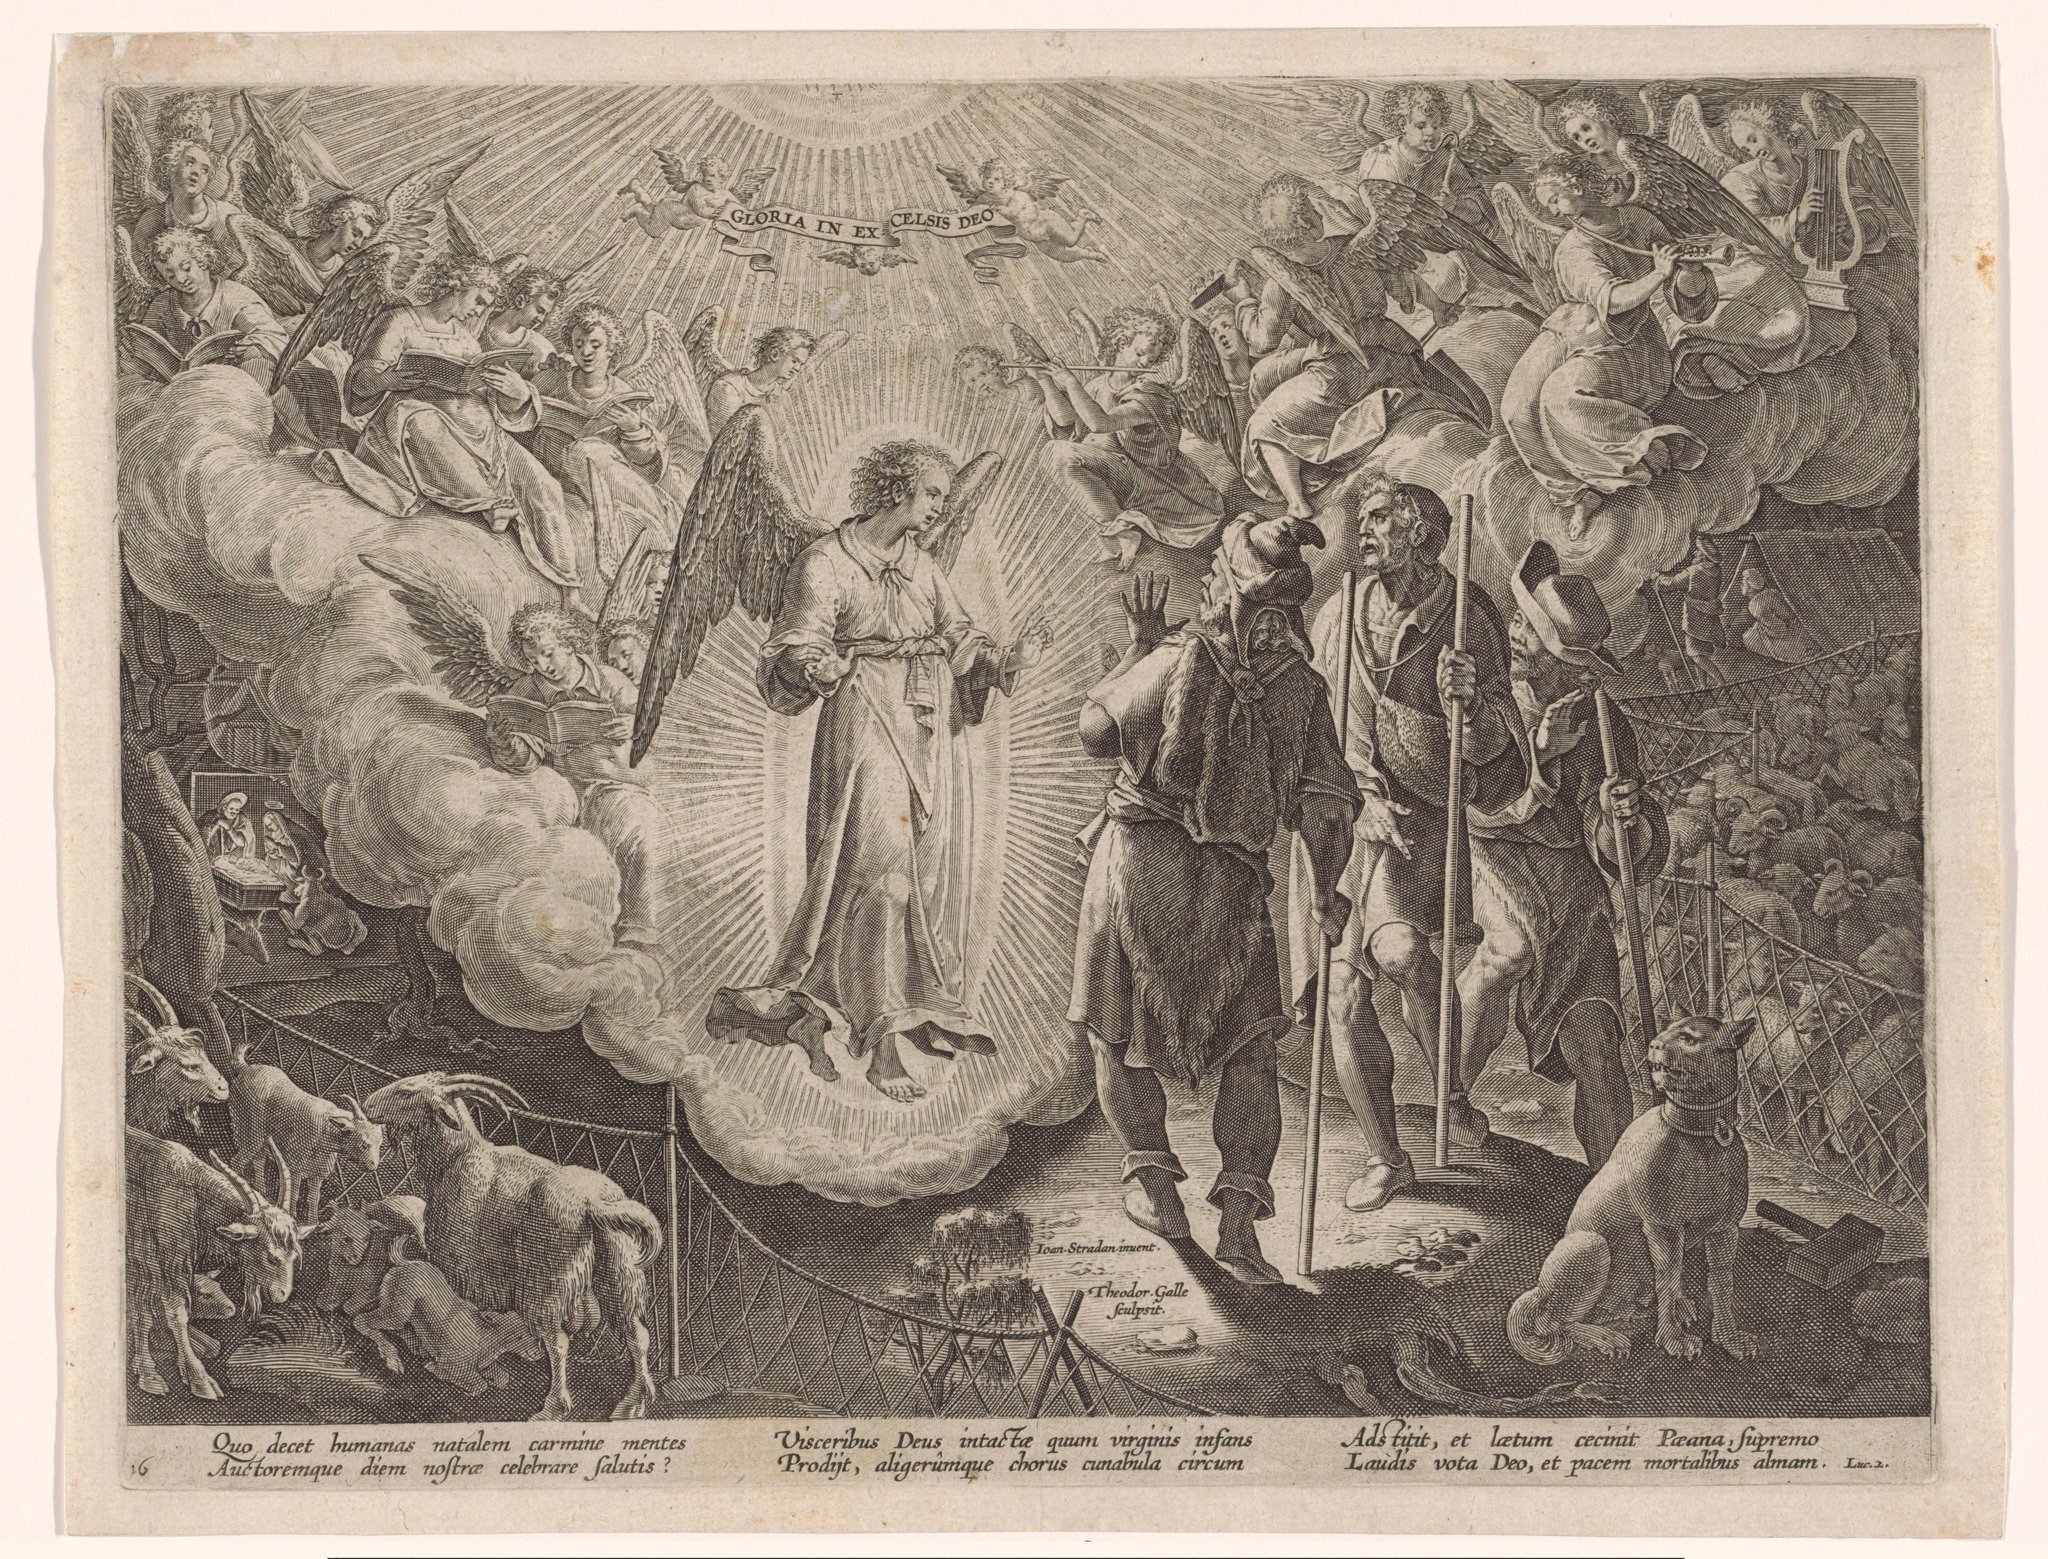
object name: print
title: Verkondiging aan de herders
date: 1586-1593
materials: paper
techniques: engraving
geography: antwerp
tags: annunciation of christ's birth to the shepherds (and/or shepherdesses) at night; a host of singing angels in the air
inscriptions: collector's mark: Lugt 2228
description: Verkondiging aan de herders. Zestiende prent uit een serie van achttien gravures naar Stradanus, met scènes uit het O.T. en N.T. die de muziek tot onderwerp hebben.